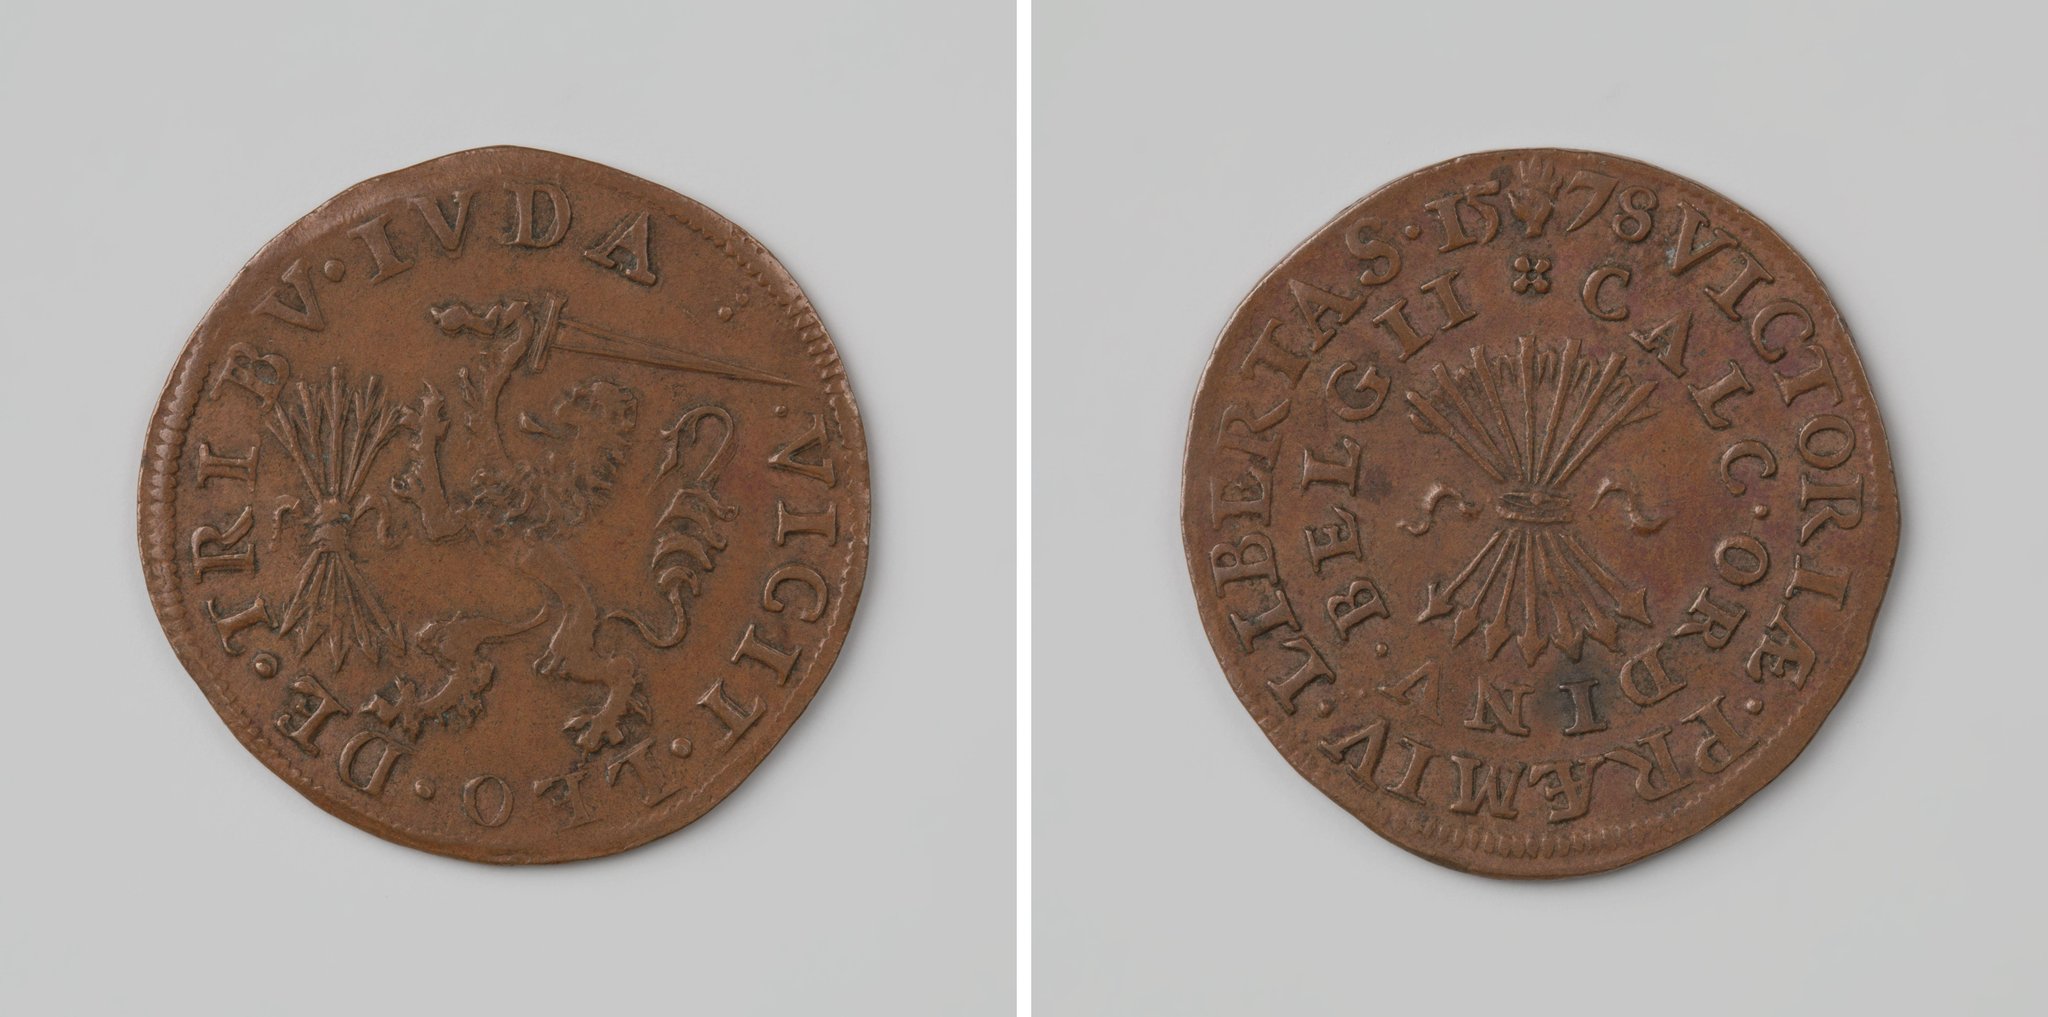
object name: jeton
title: Overwinning van de opstandelingen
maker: Anonymous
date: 1578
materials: copper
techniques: striking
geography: antwerp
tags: staten-generaal, tachtigjarige oorlog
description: Koperen penning. Voorzijde: leeuw met zwaard en bundel van vijf pijlen in klauwen binnen omschrift. Keerzijde: bundel van zeven pijlen binnen tweeregelig omschrift